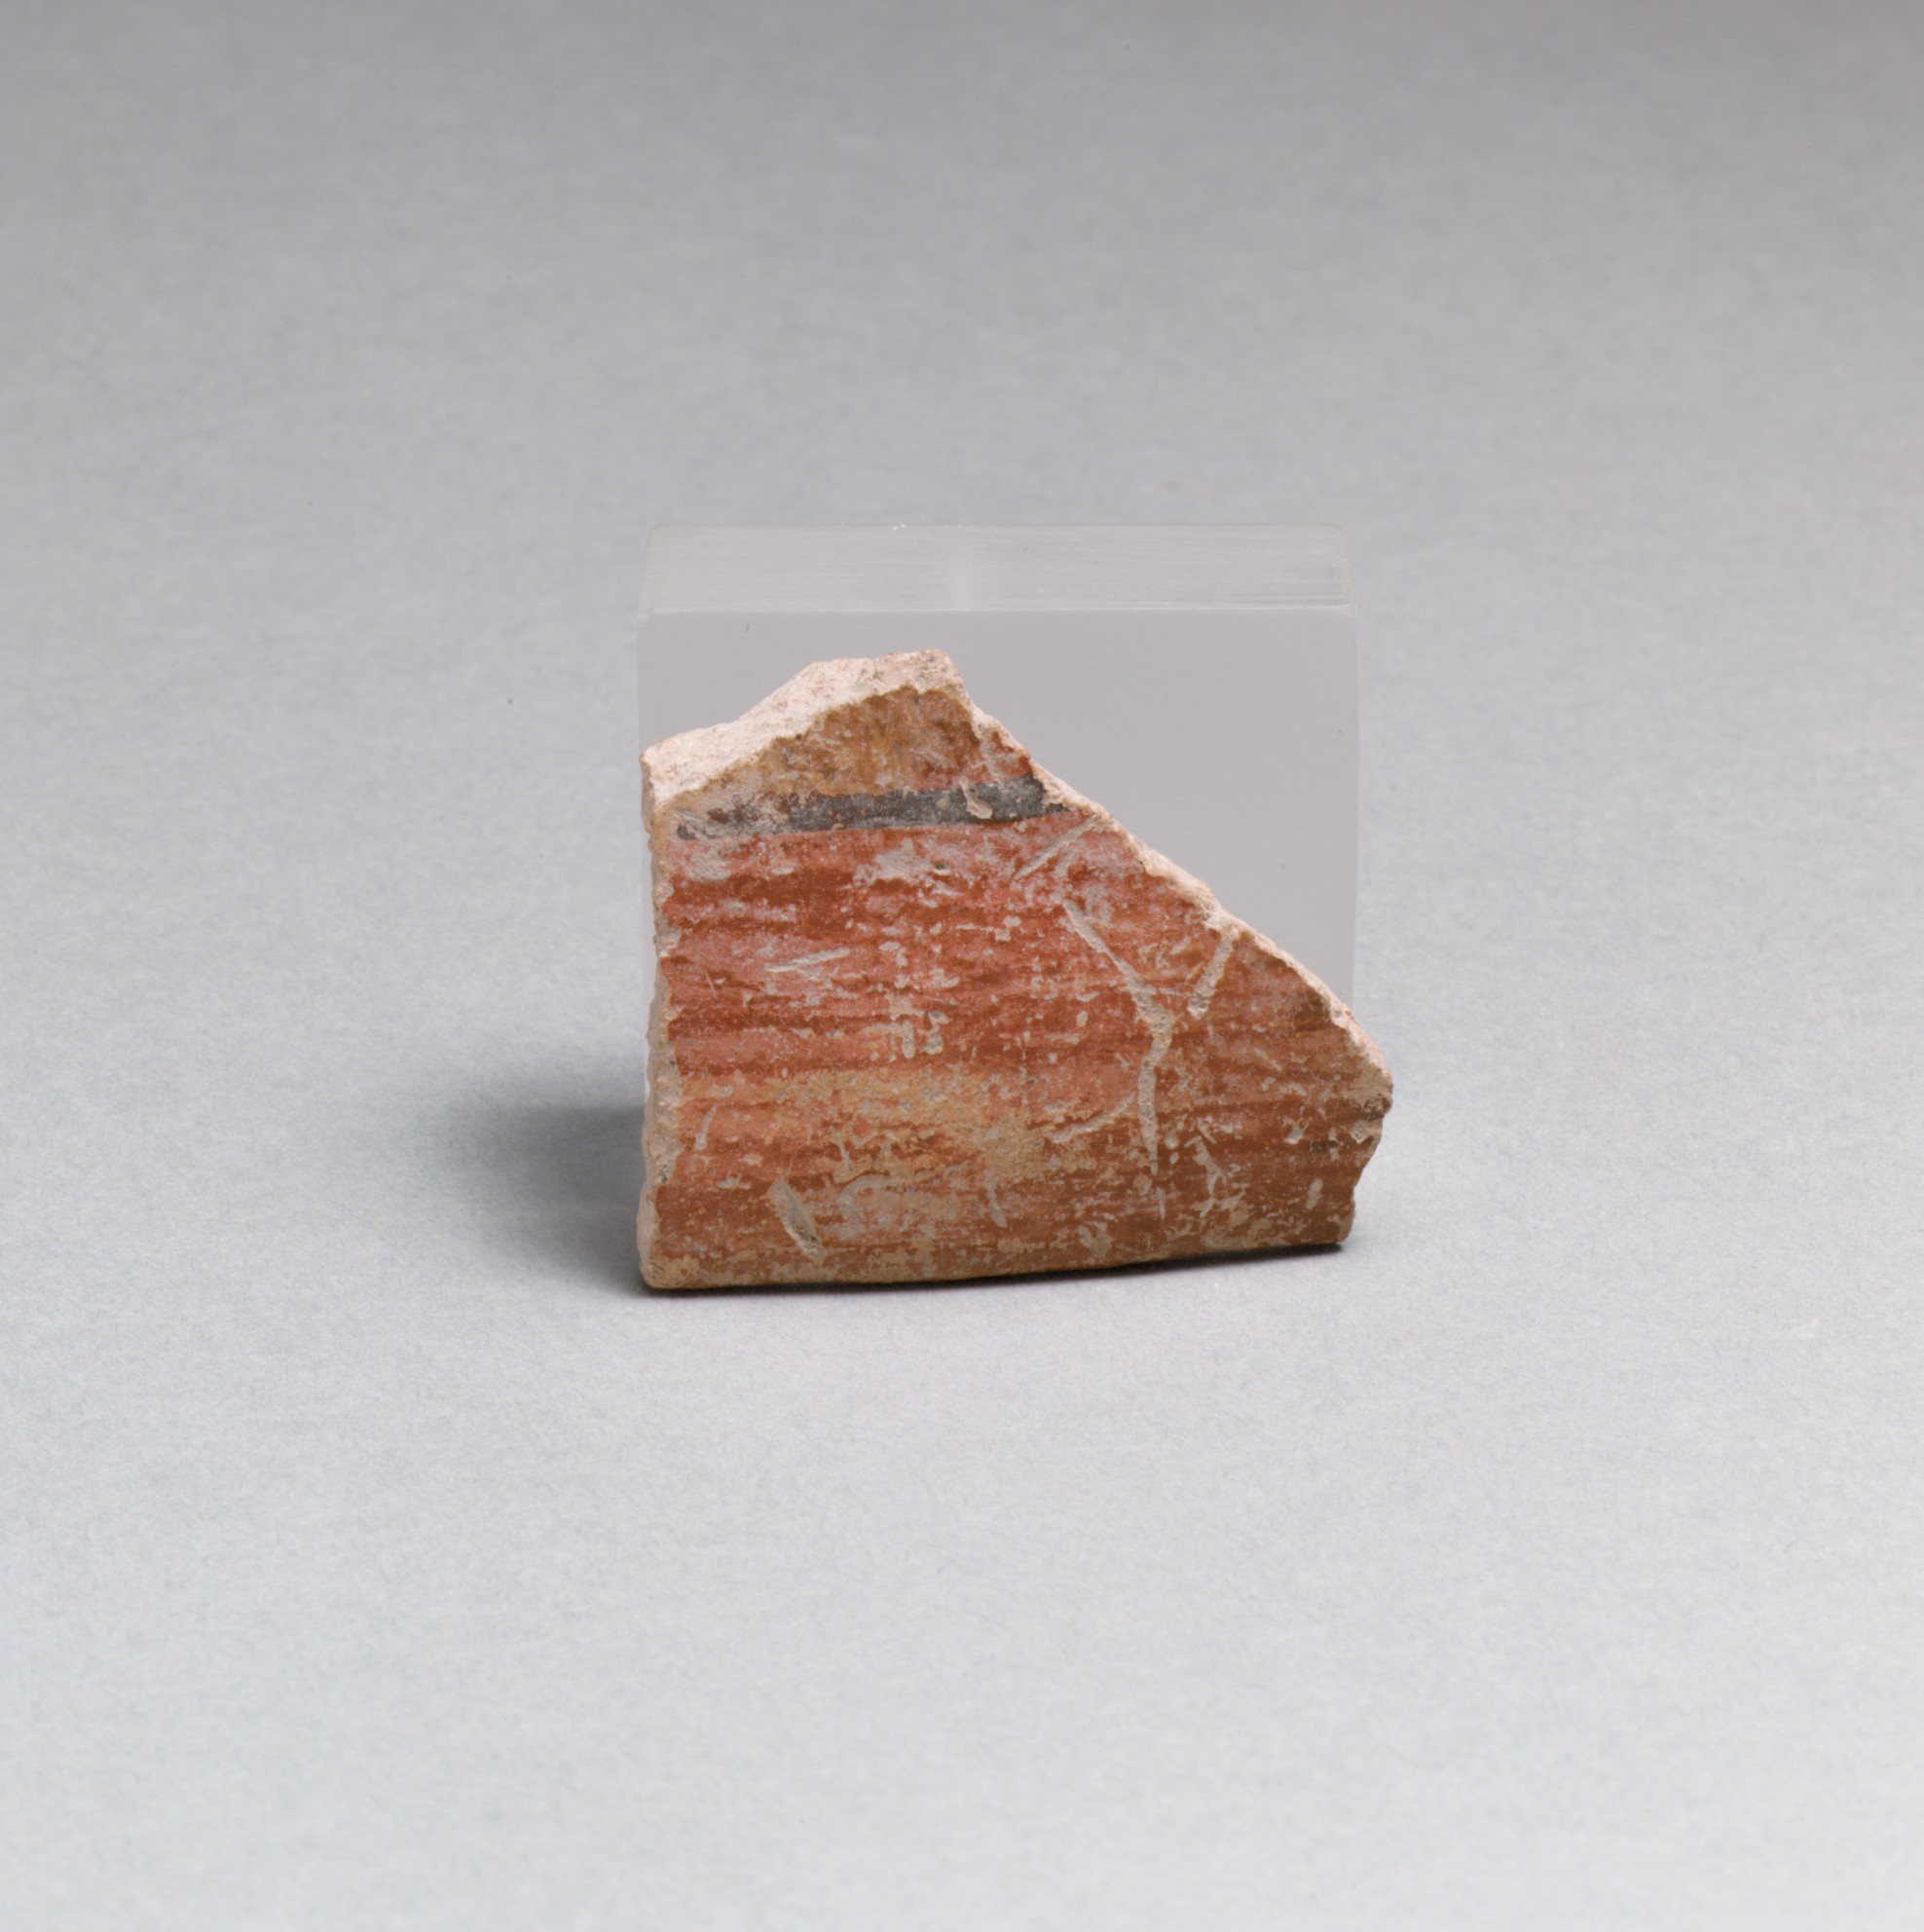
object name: vase fragment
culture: neolithic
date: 4000-3000 BCE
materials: terracotta